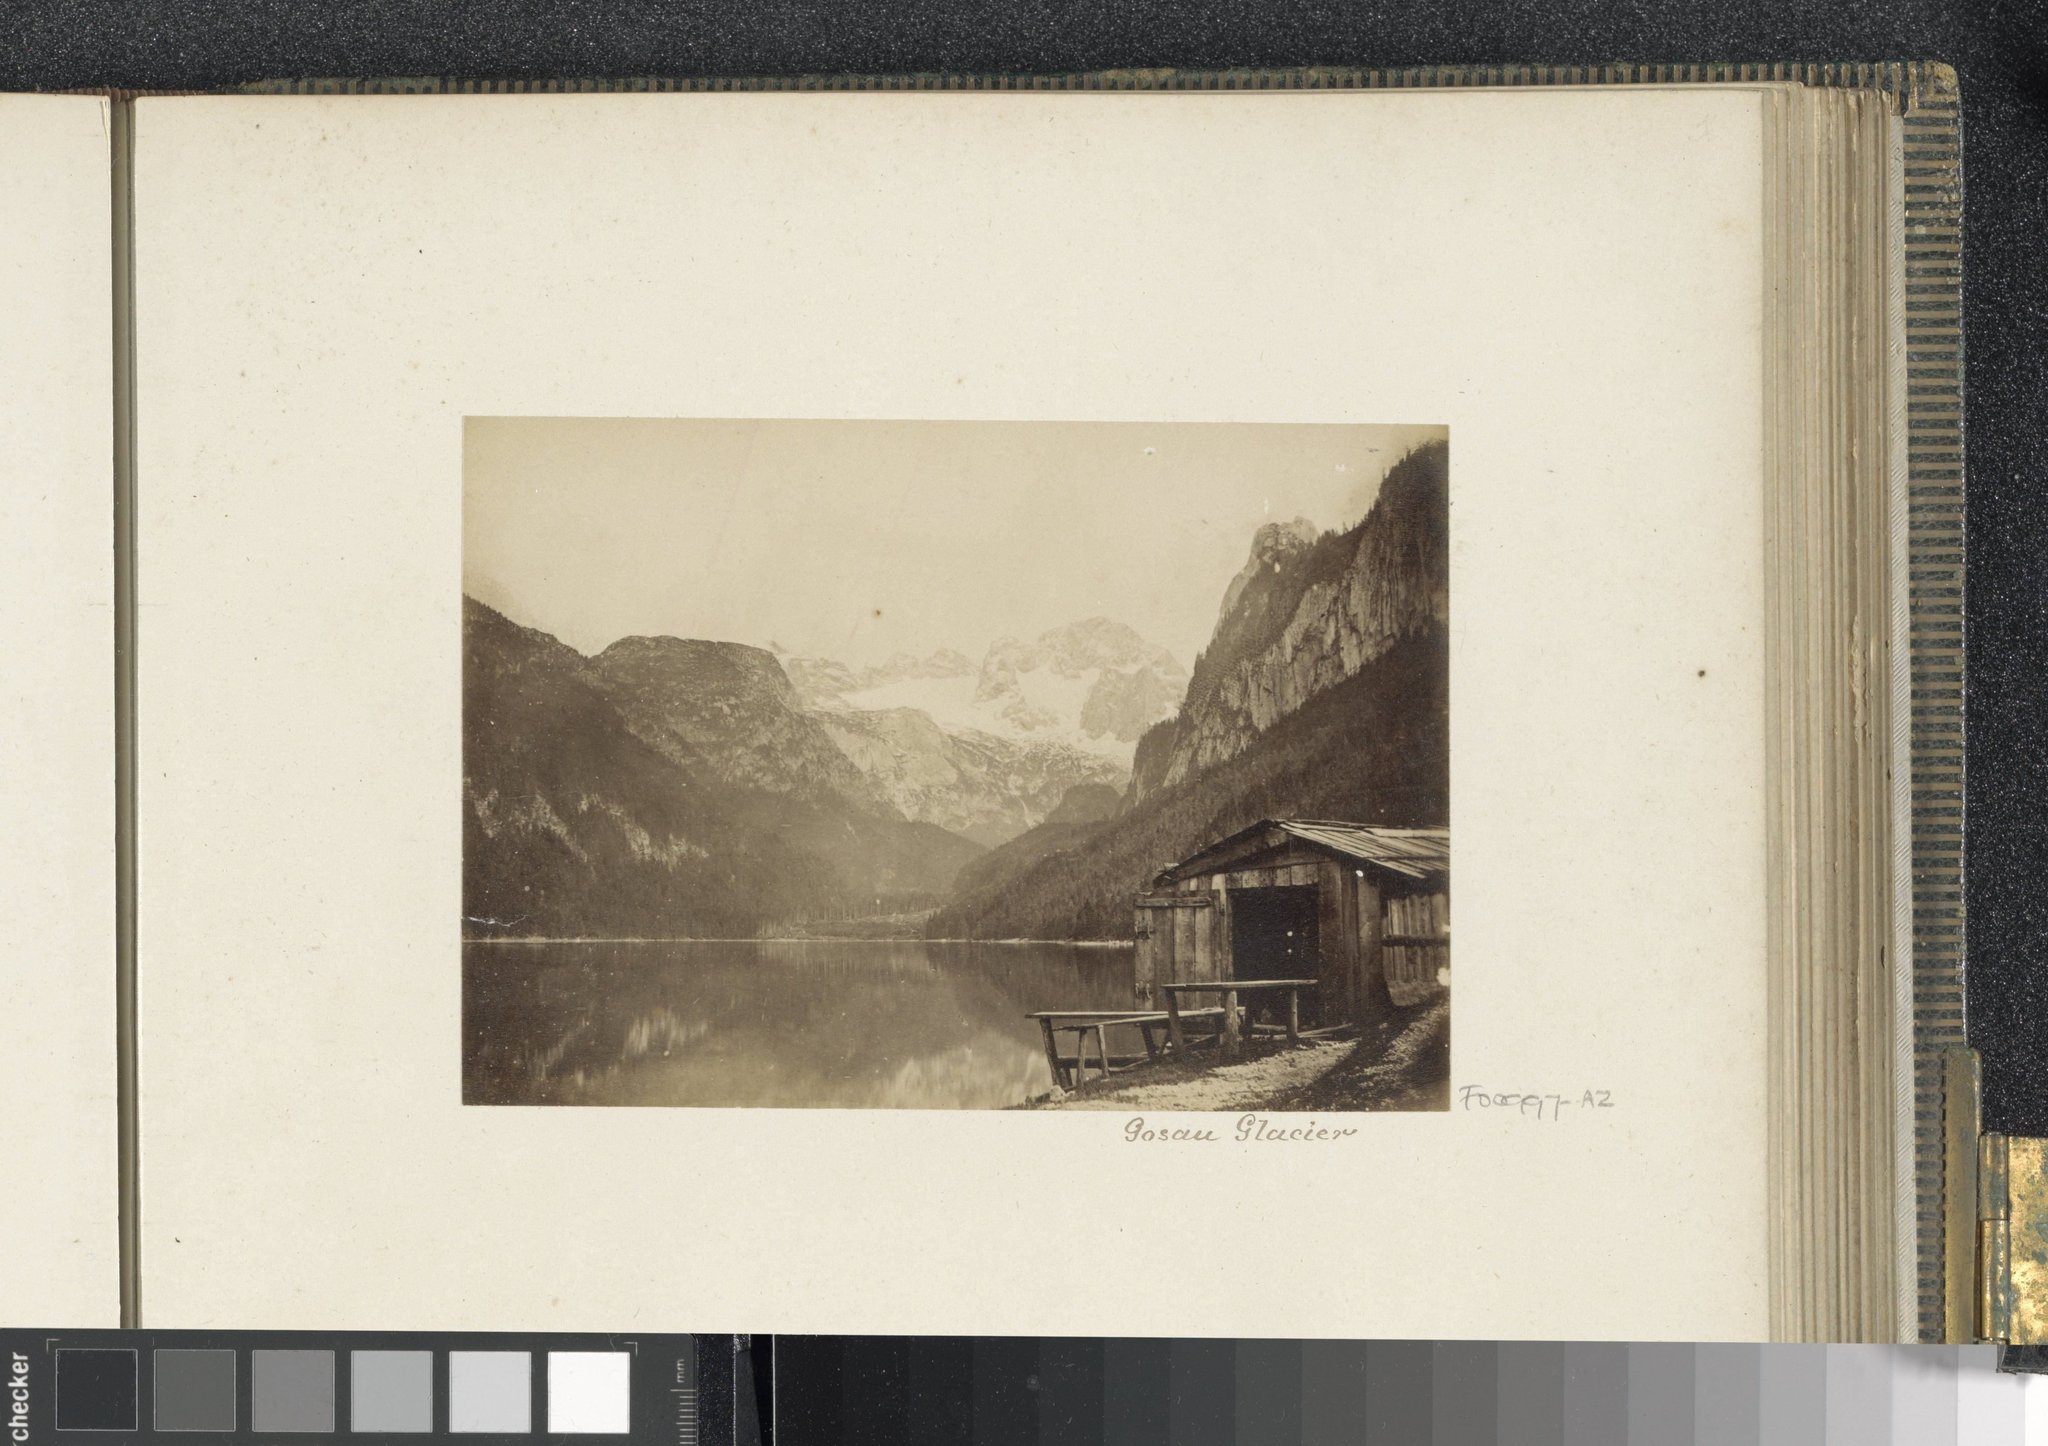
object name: photograph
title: Gezicht op de Gosaugletsjer met op de voorgrond een bergmeer en een hut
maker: Anonymous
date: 1860-1890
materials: paper, photographic support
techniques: albumen print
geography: salzburg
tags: glacier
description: Onderdeel van Reisalbum met foto's van Zwitserland, Oostenrijk, Italië en Duitsland.